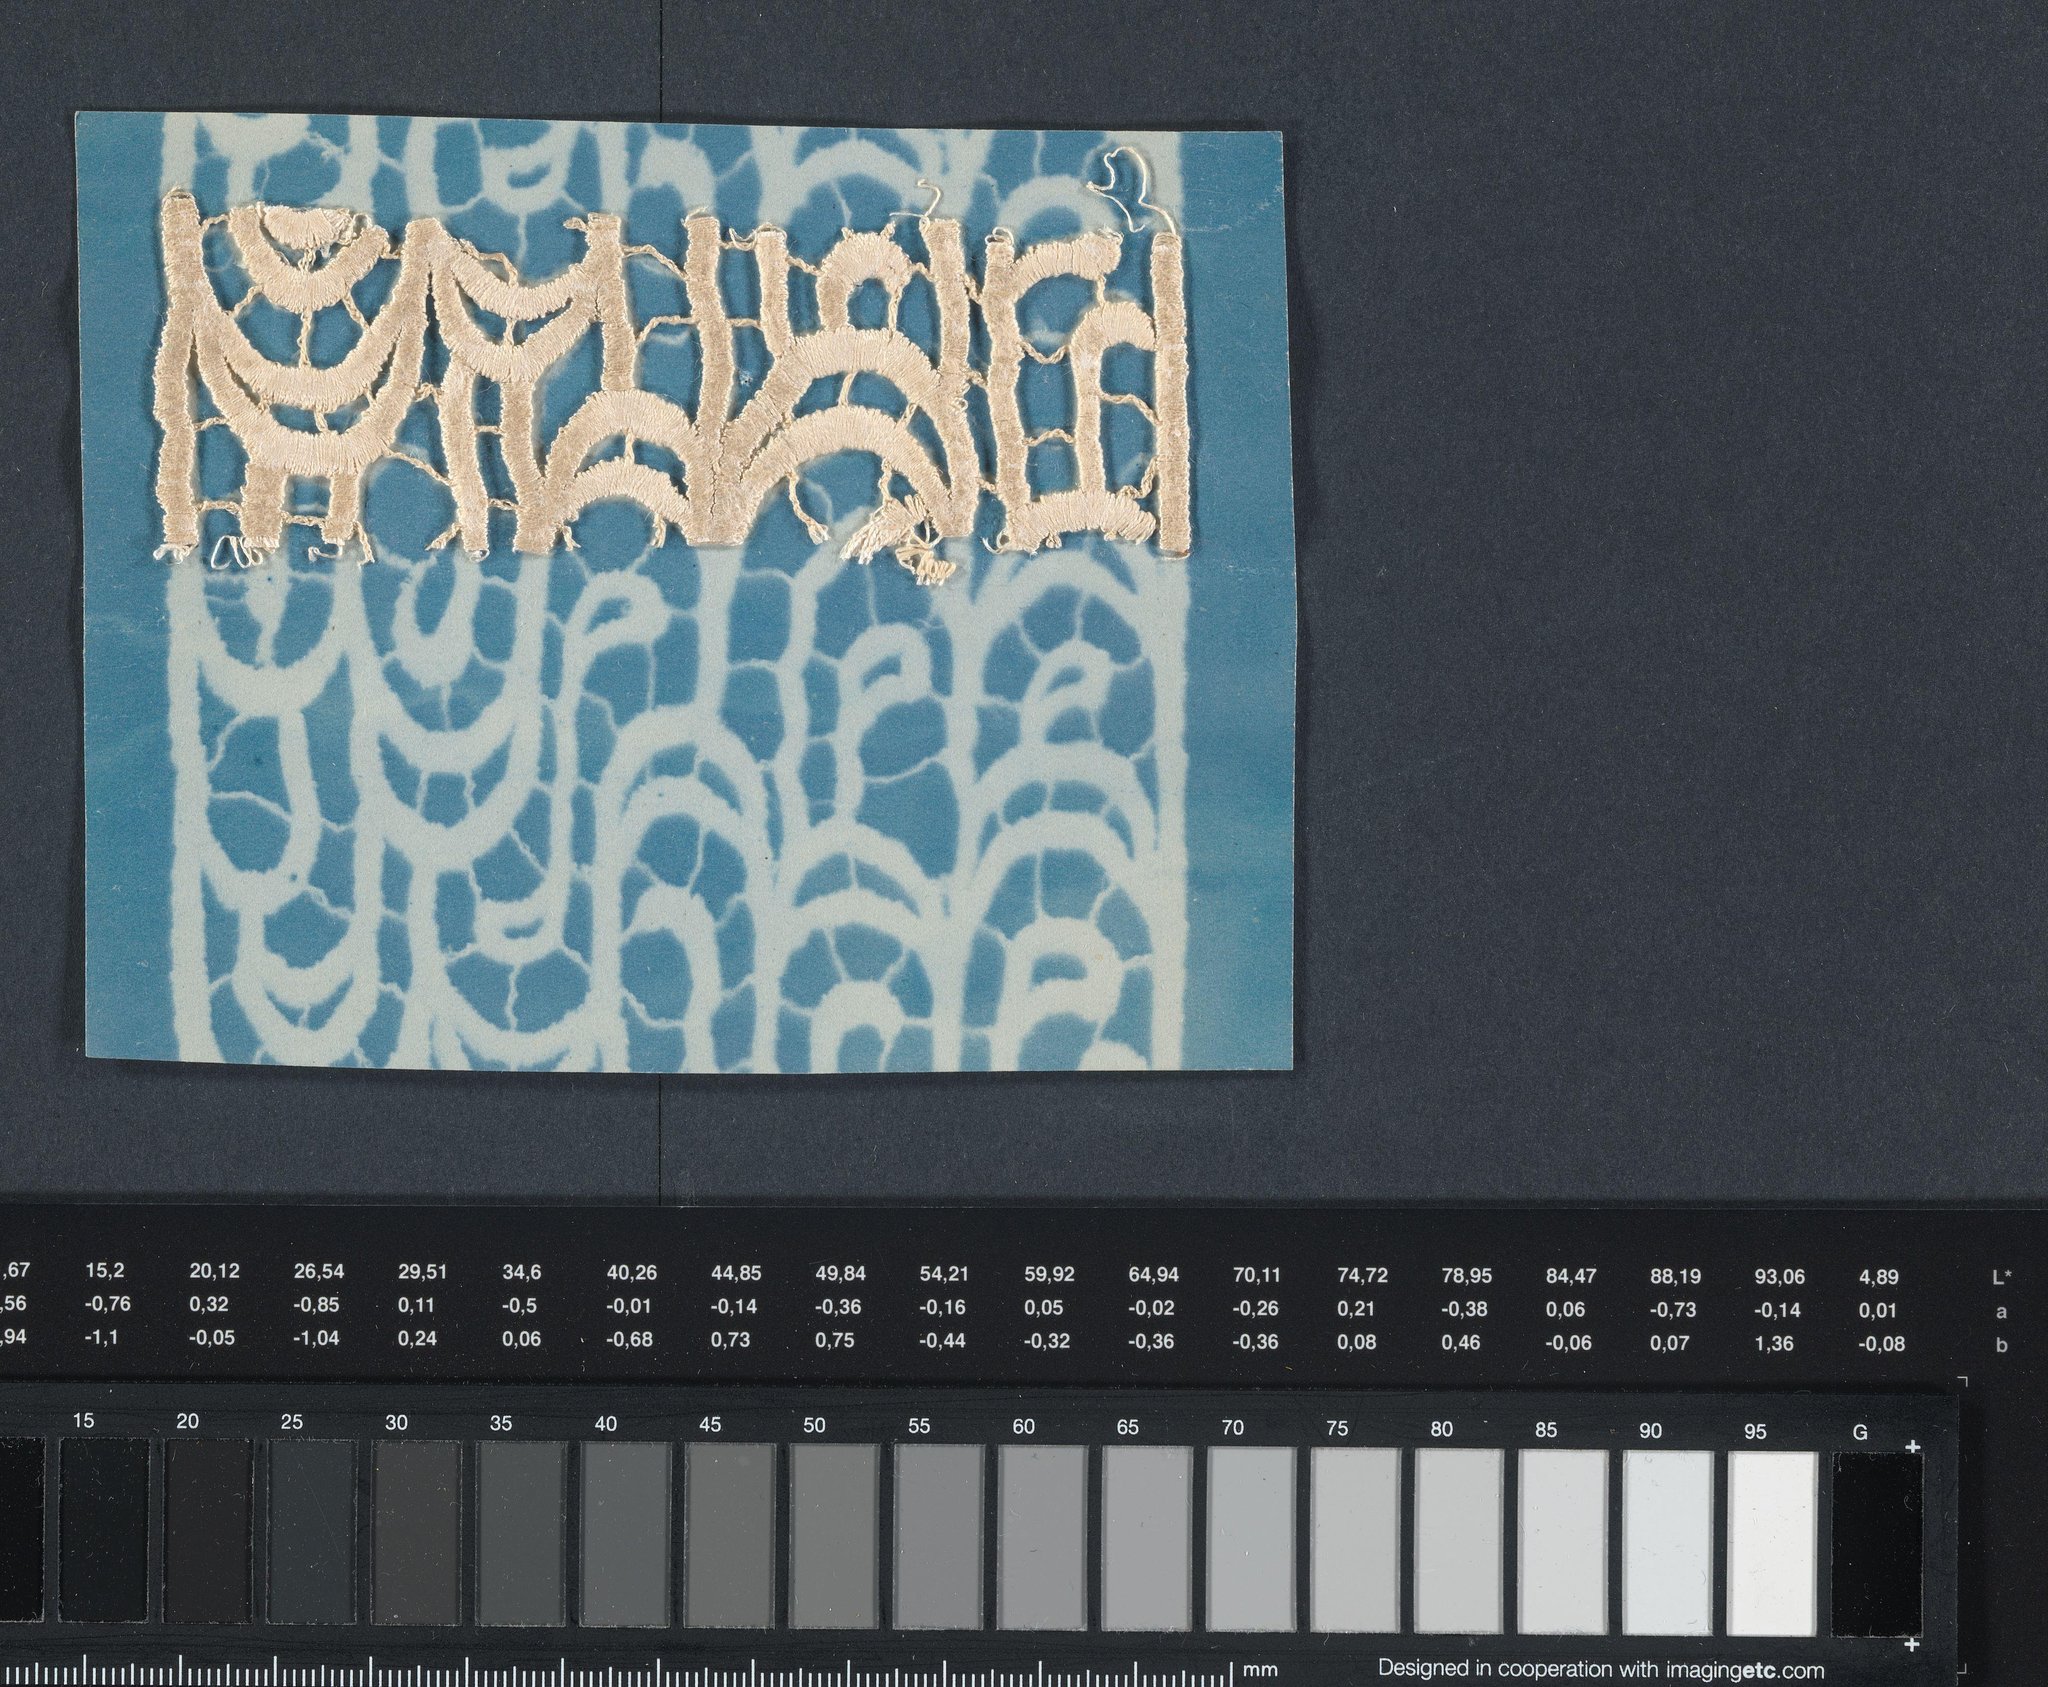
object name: photogram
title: Kant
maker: Anonymous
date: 1900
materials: paper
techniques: cyanotype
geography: france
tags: lace